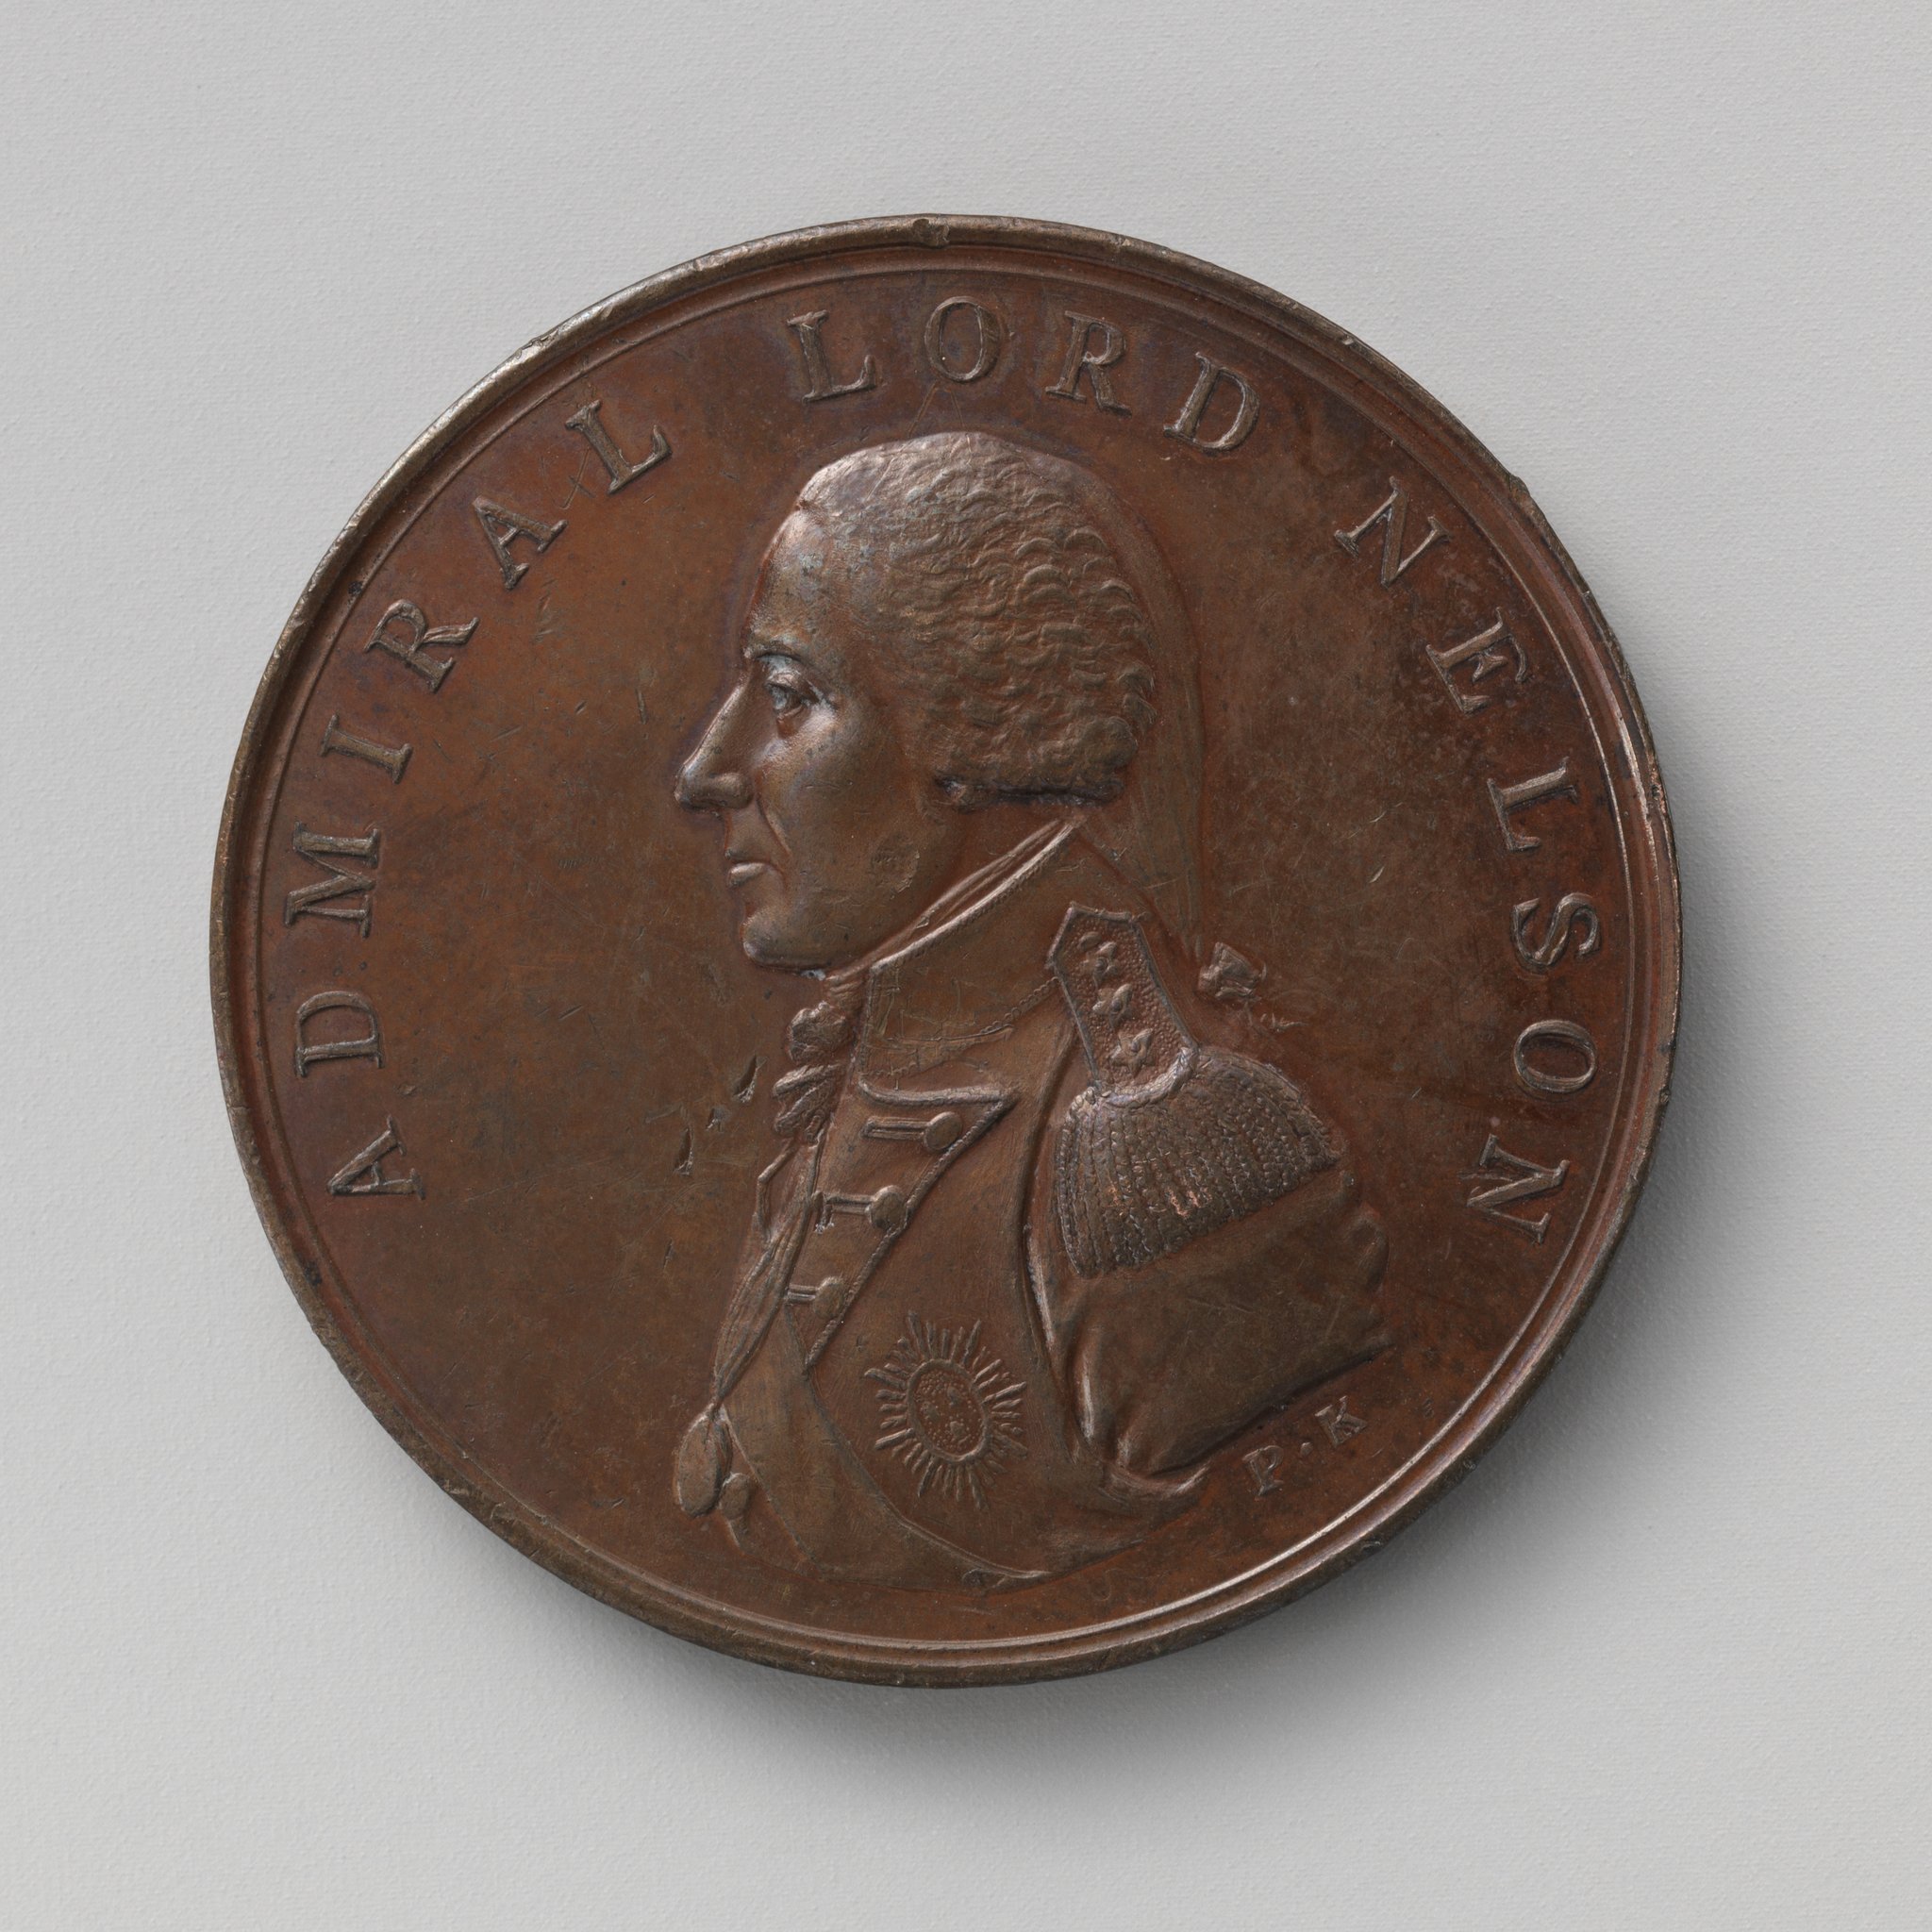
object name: medal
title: Battle of the Nile, 1798, and Nelson's return, 1800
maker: peter kempson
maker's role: artist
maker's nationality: british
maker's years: 1750-1850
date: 1800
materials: bronze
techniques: struck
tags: men,profiles,admirals